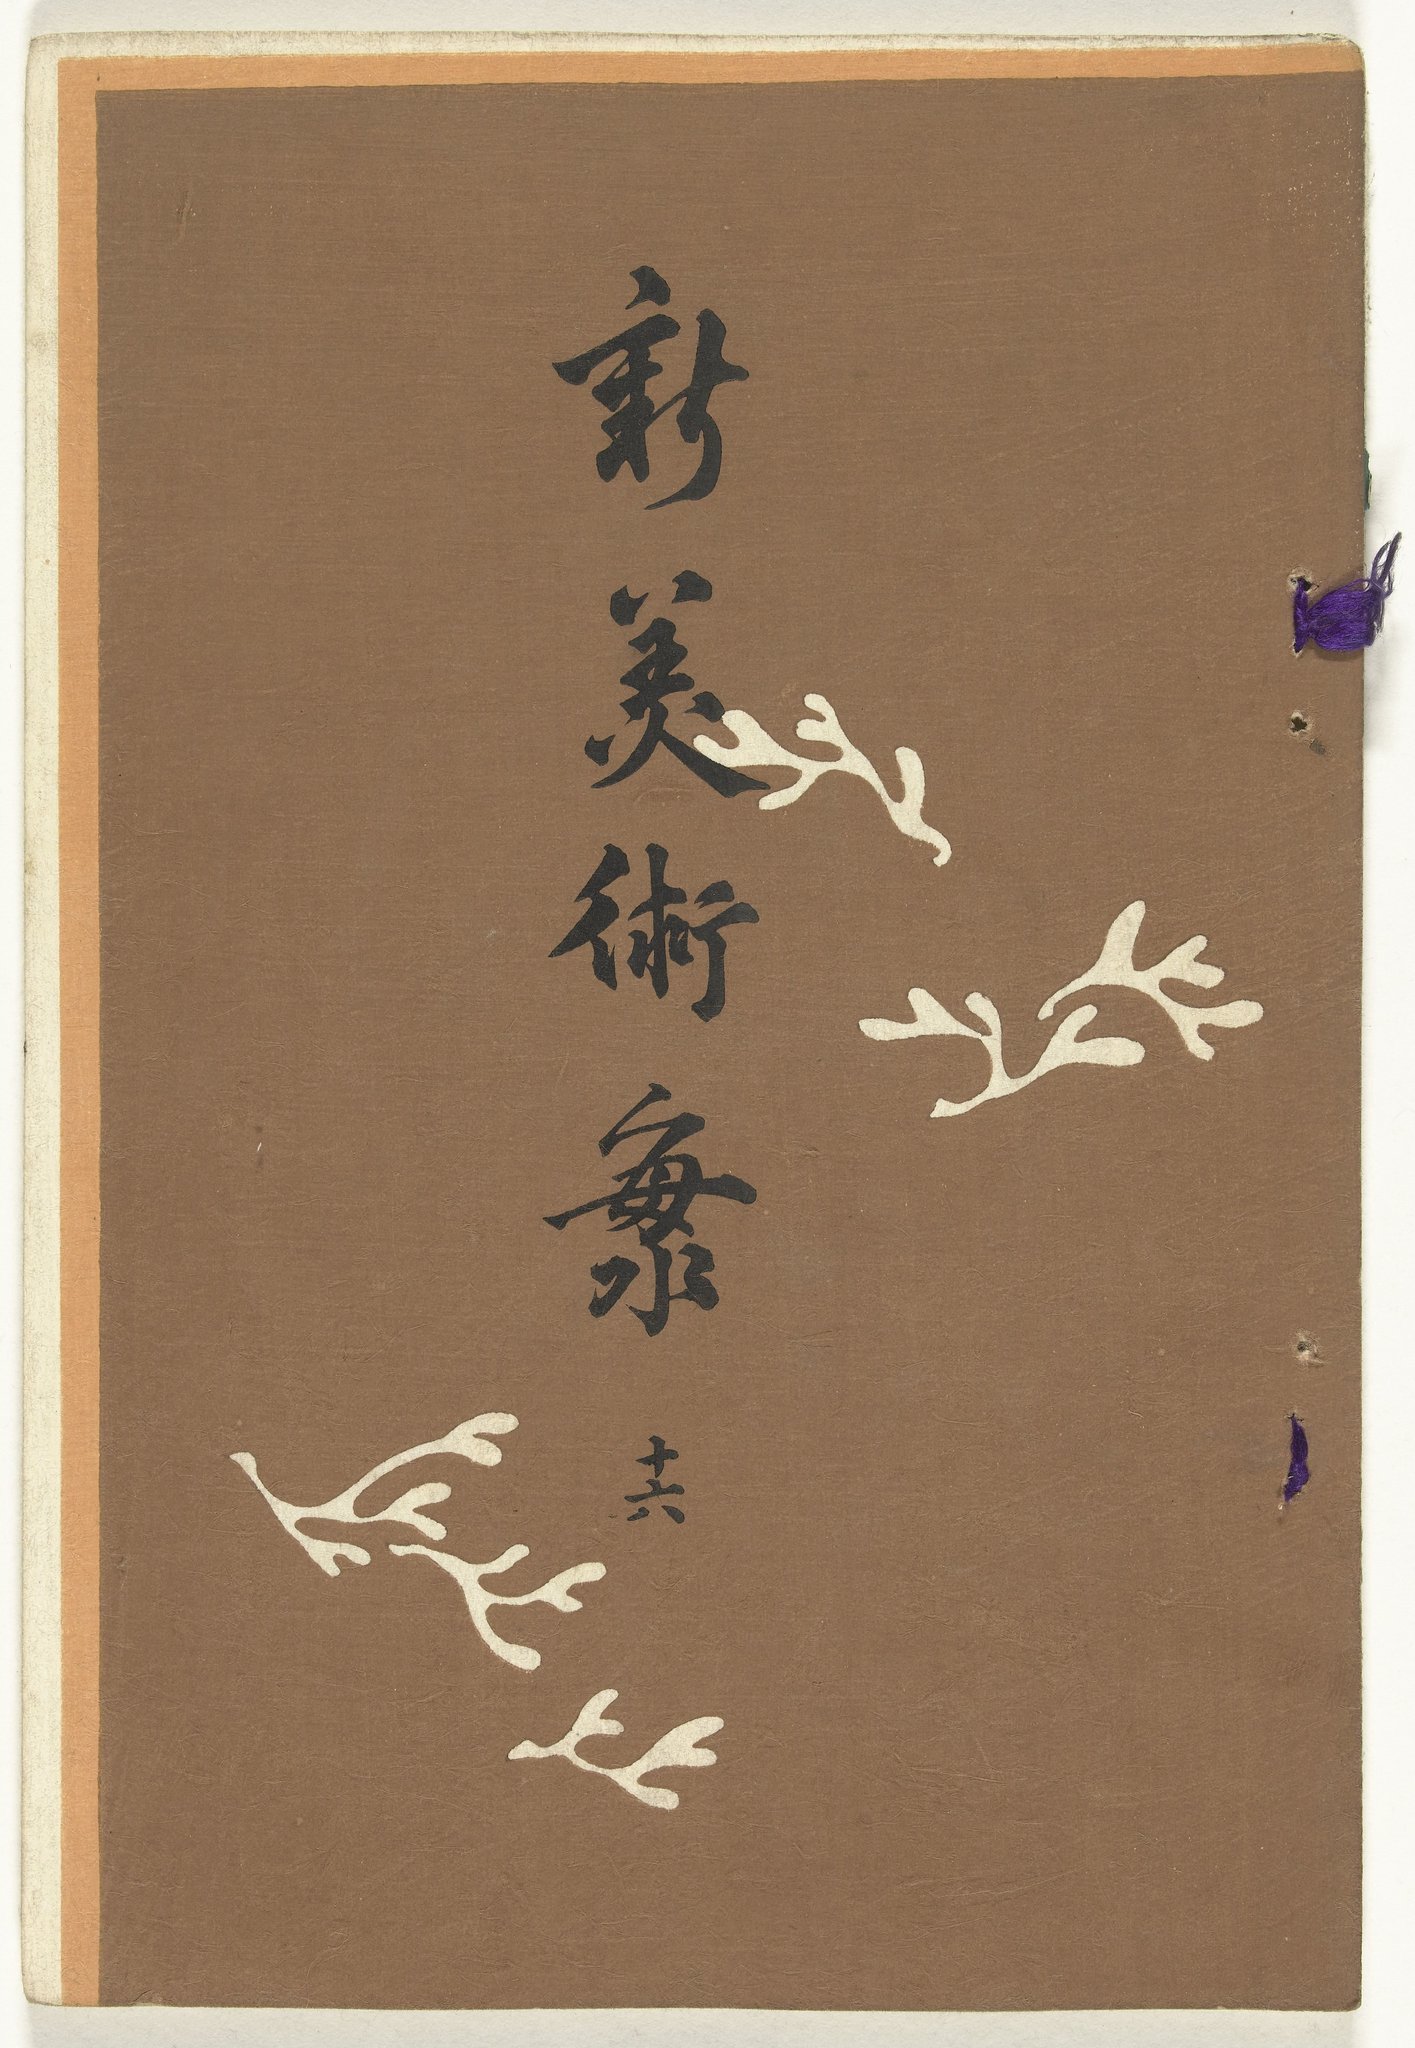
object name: book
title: Nieuwe zee der kunsten - 16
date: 1903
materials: paper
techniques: woodcut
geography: kyoto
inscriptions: date